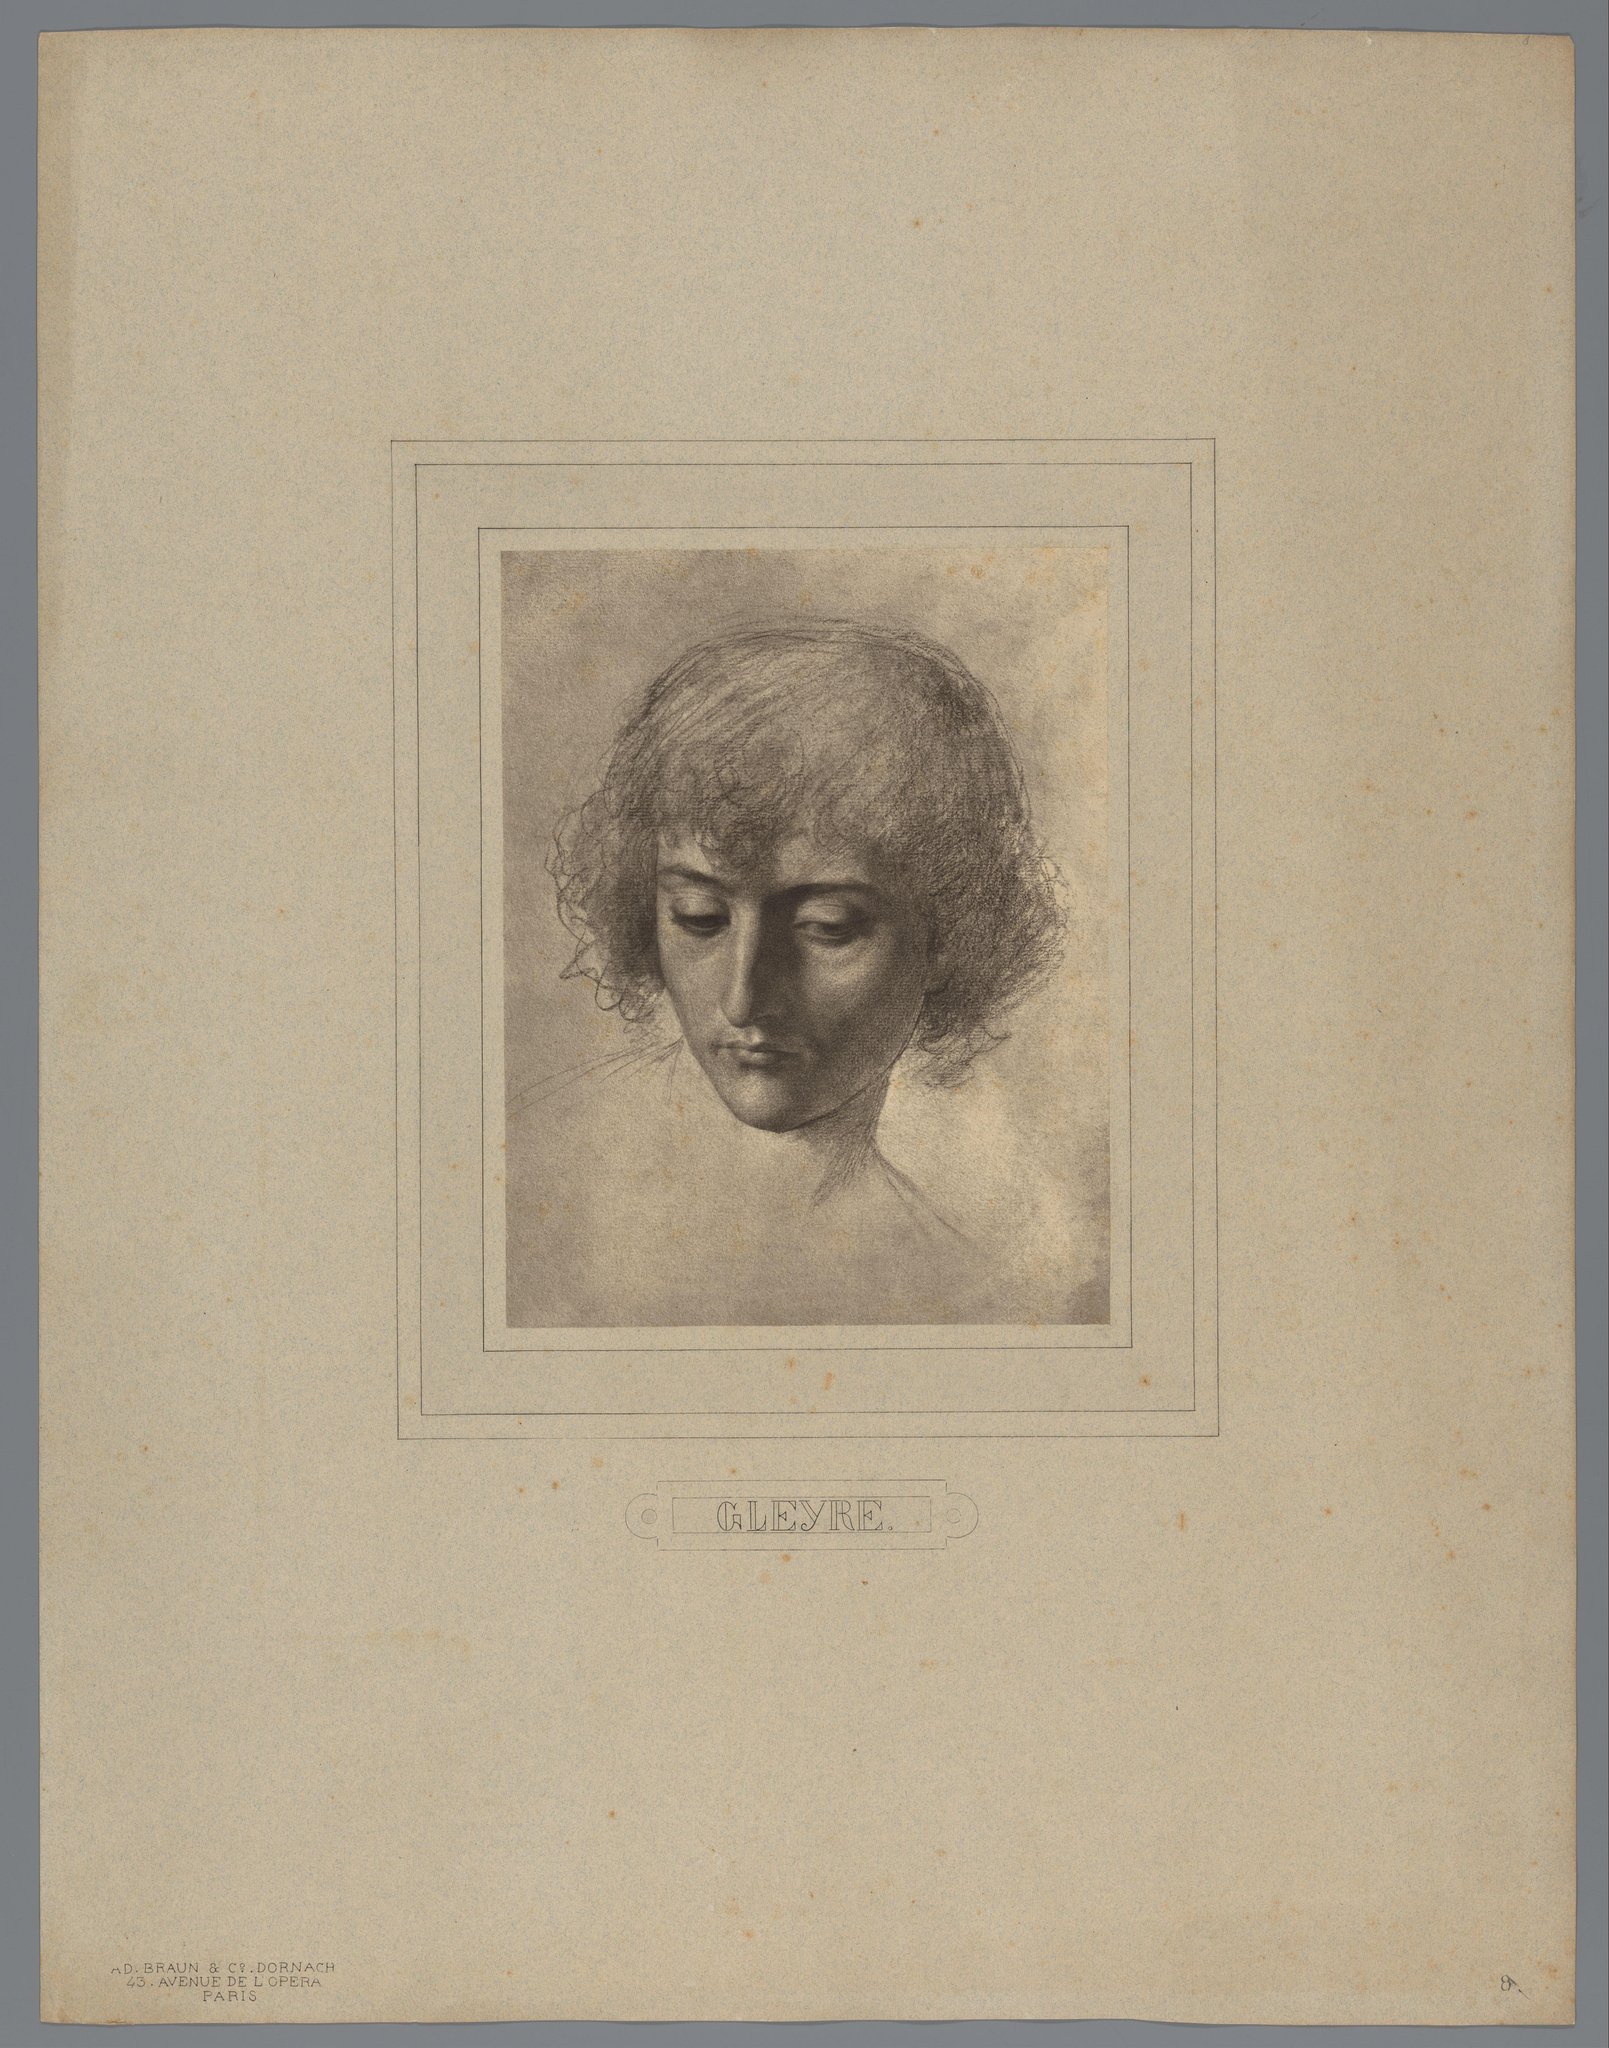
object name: photograph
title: Fotoreproductie van een tekening van Charles Gleyre (kop van een jongeman)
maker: m.m. couvée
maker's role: publisher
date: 1880-1900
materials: cardboard, paper, photographic support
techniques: carbon print